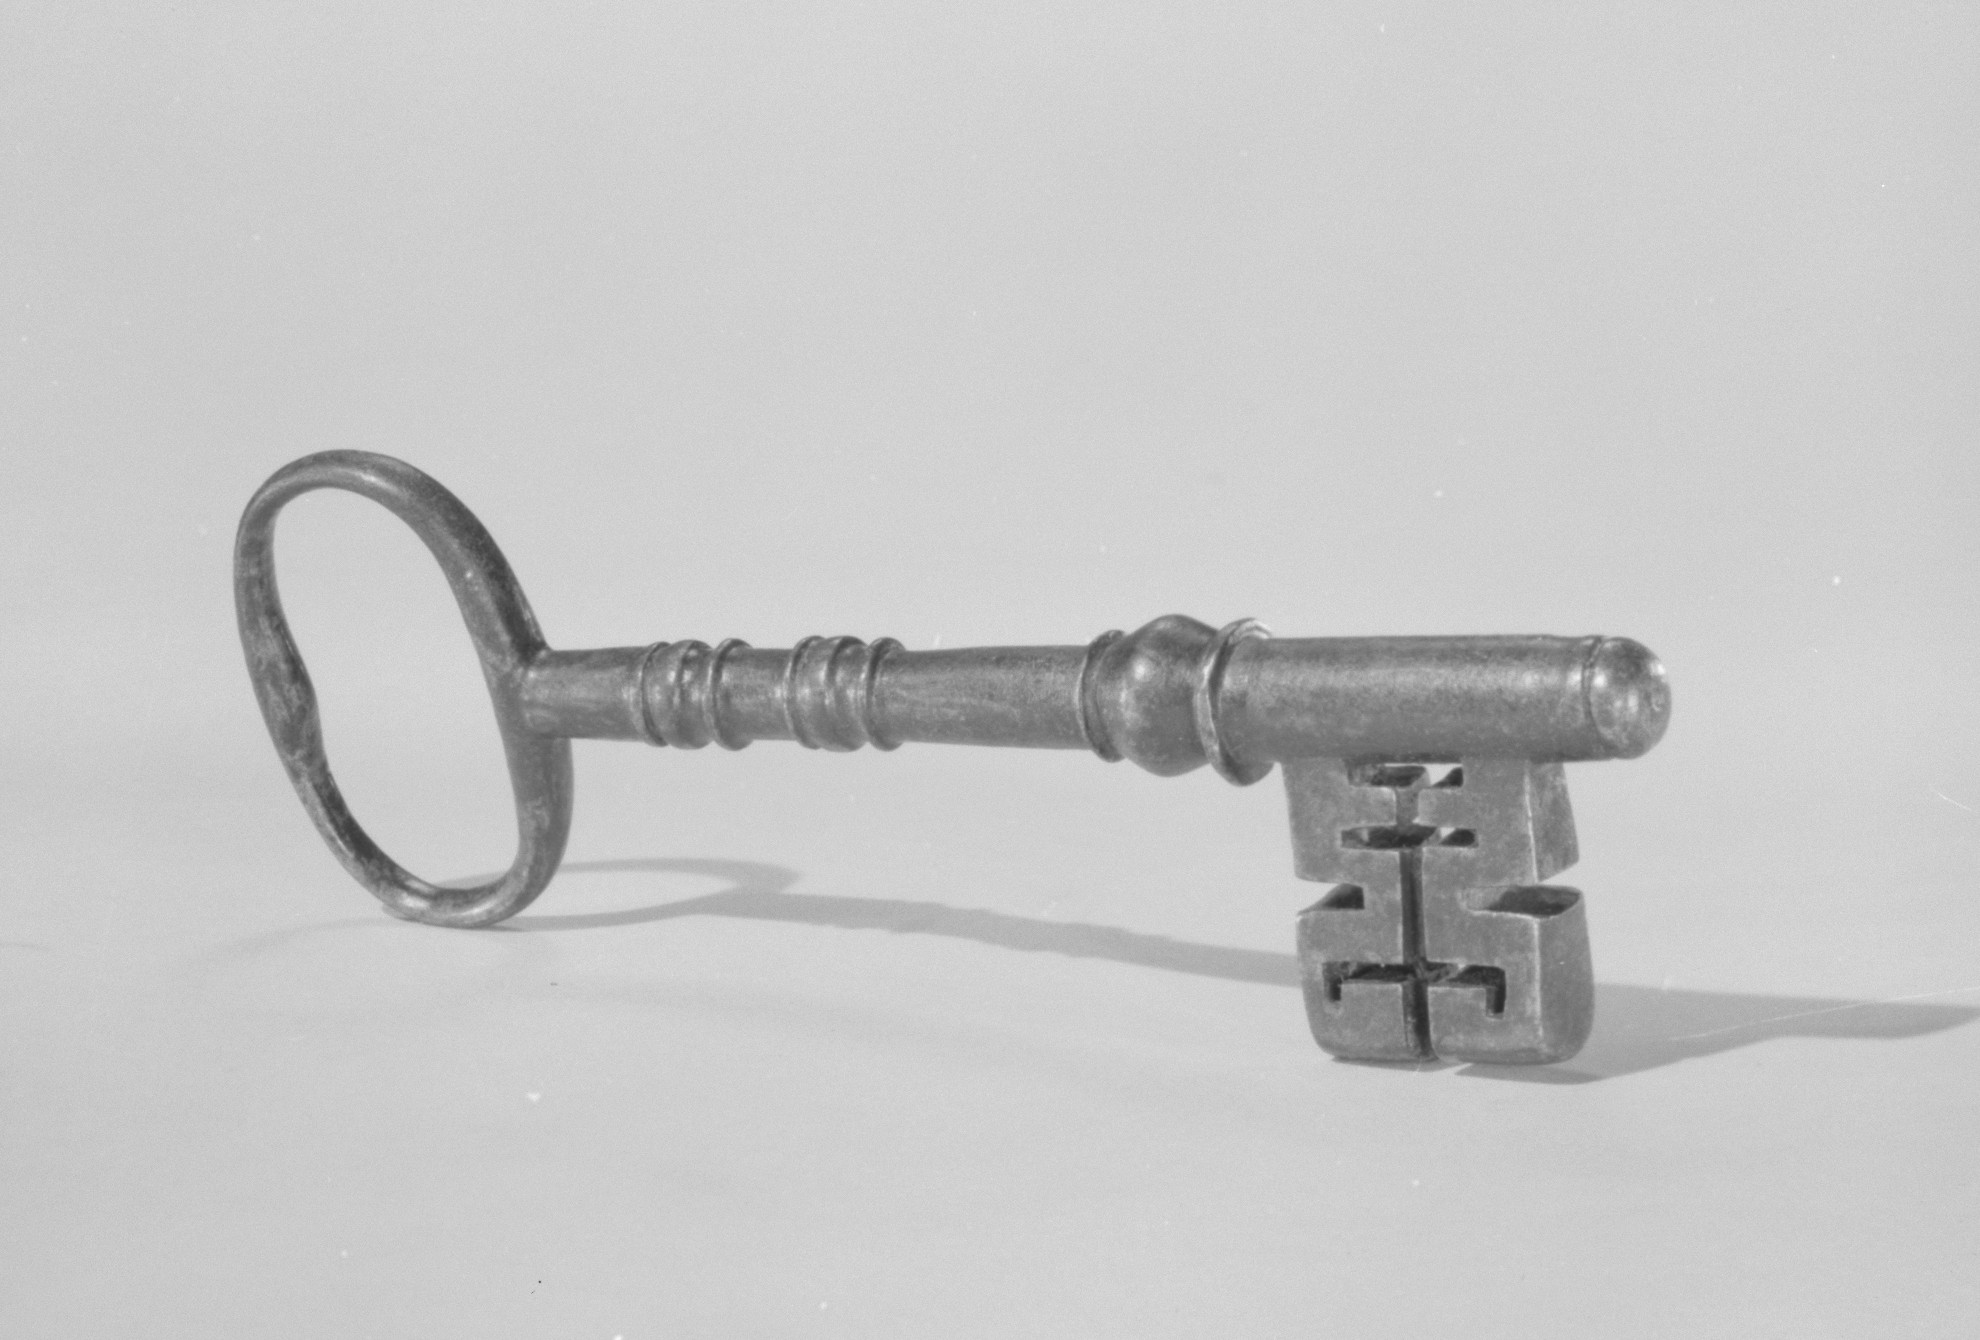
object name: key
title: Pin key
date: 1701-1800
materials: iron